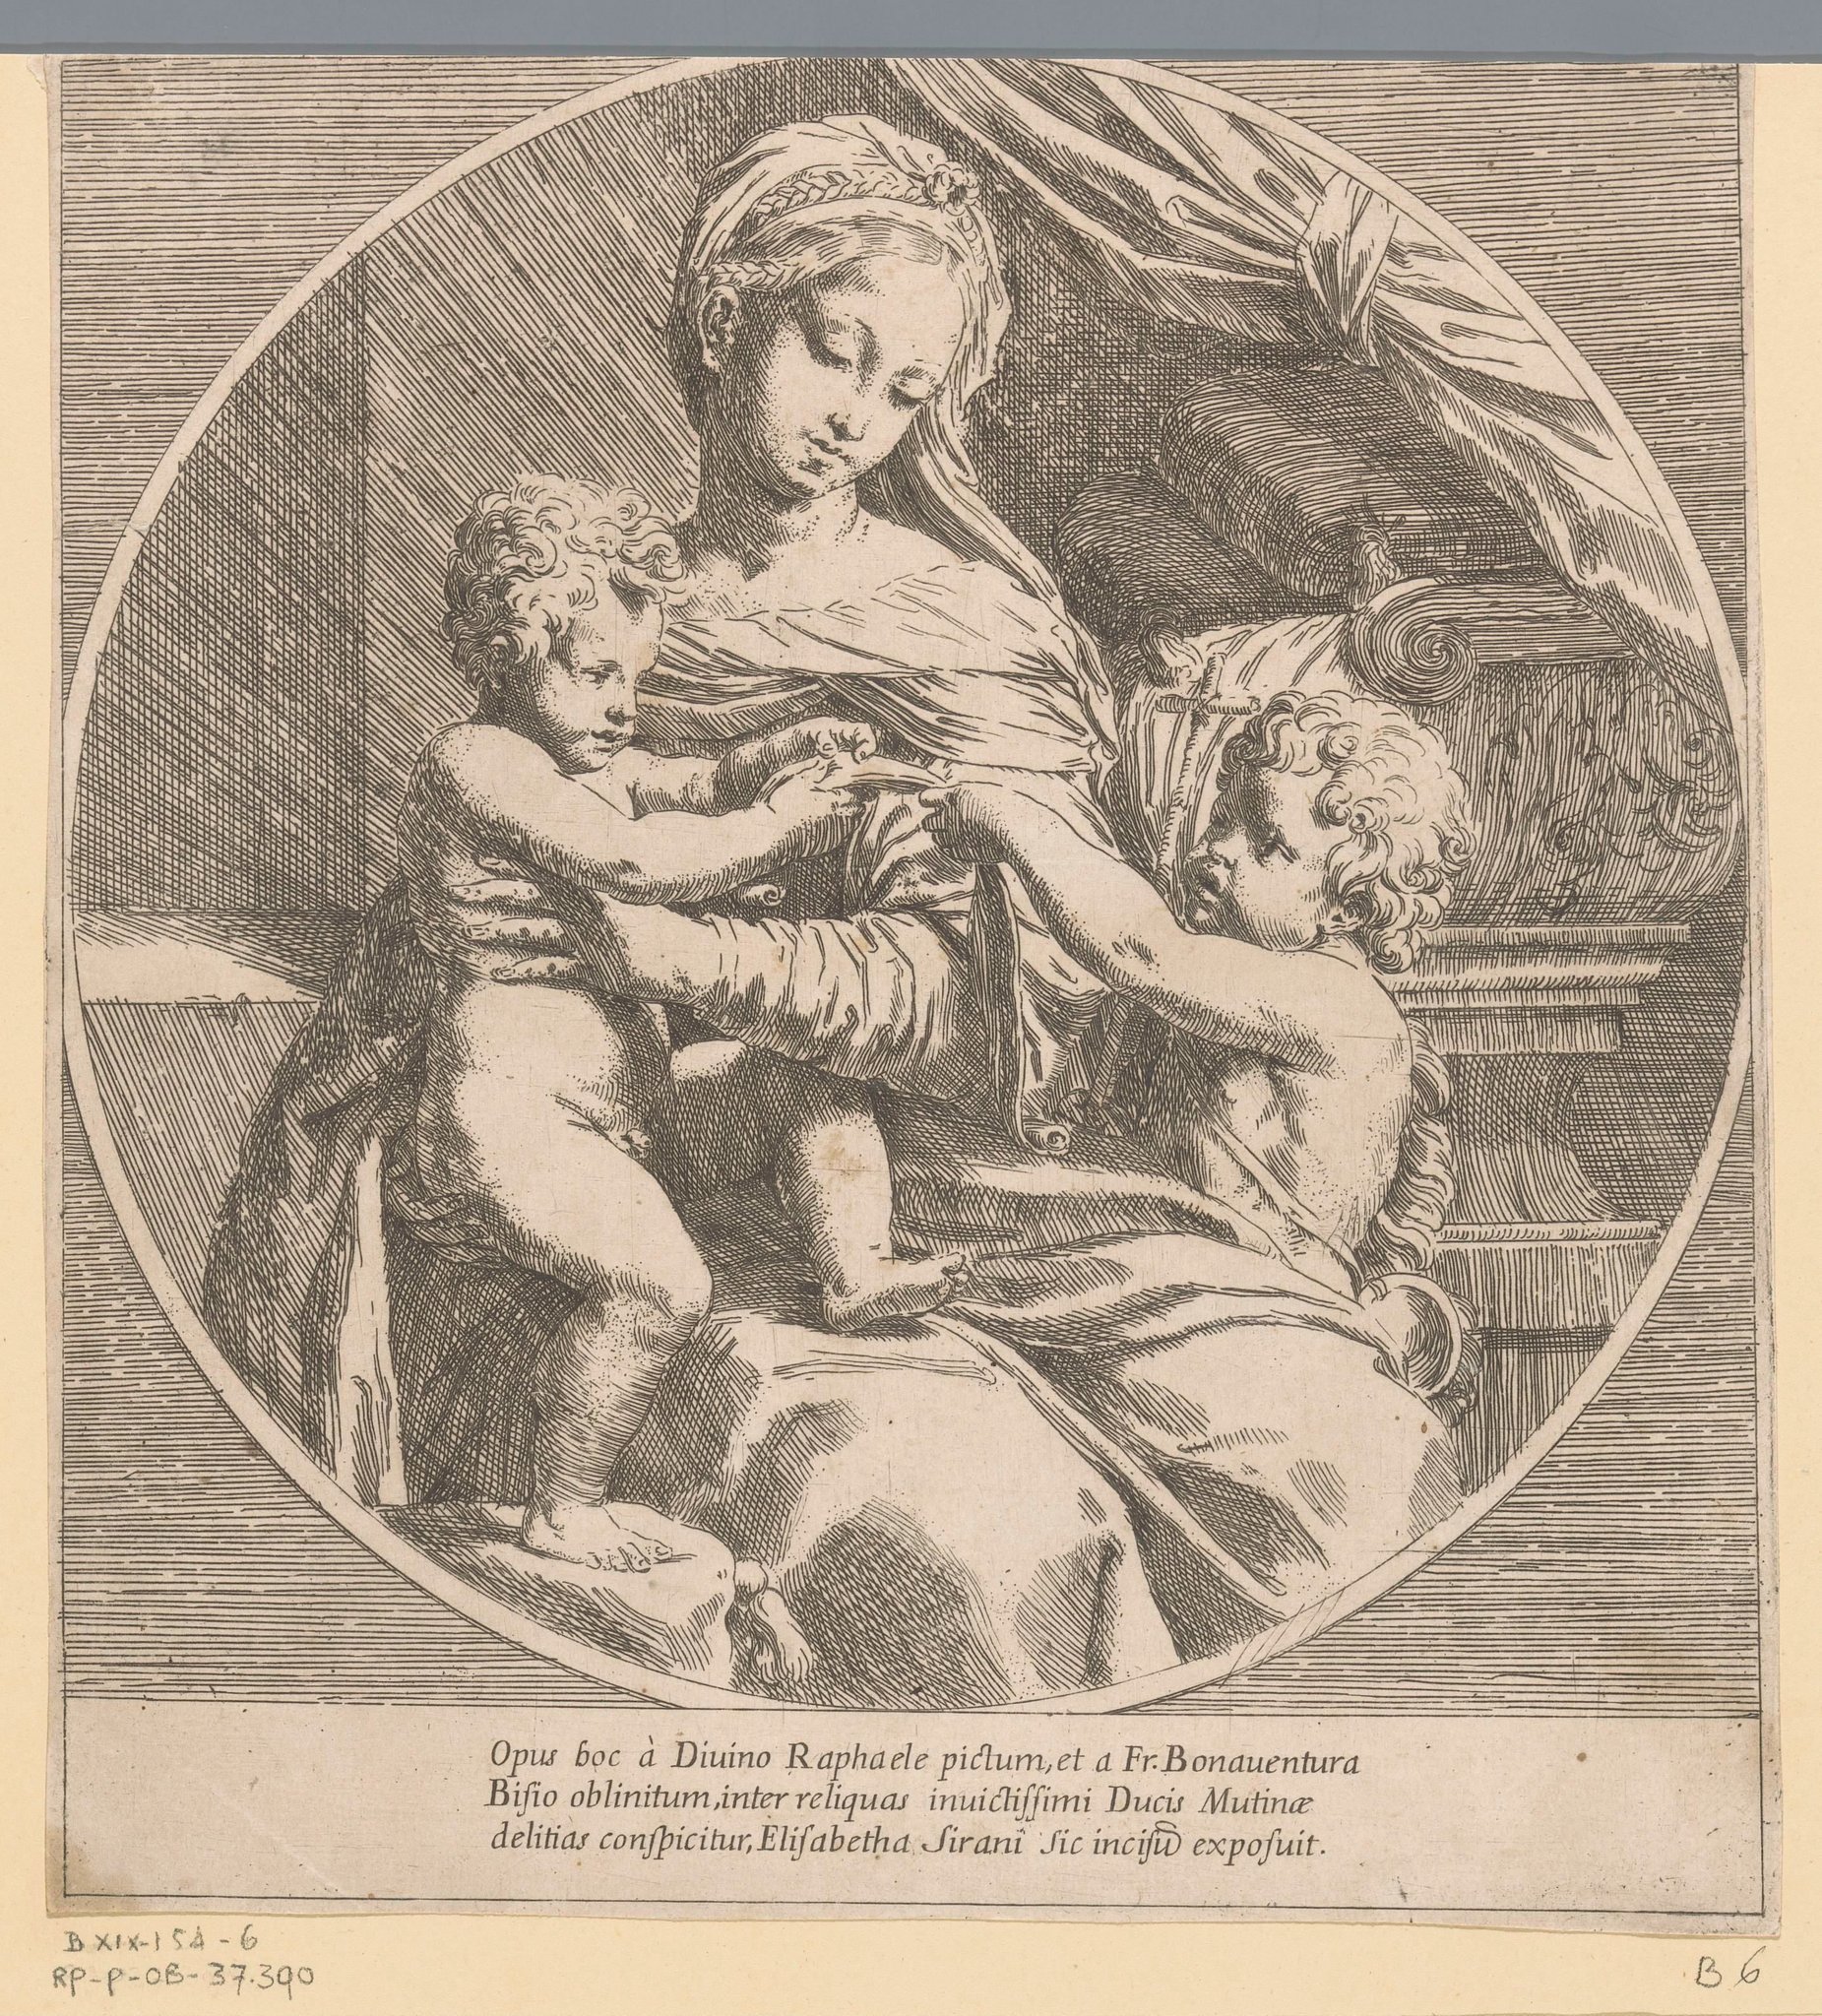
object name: print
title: Maria met Kind en de jonge Johannes de Doper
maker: elisabetta sirani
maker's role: draughtsman, print maker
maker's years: 1638-1665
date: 1648-1665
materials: paper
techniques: etching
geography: italy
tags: mary and the christ-child with john the baptist (as child)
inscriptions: collector's mark: Lugt 240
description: Drieregelige Latijnse tekst in ondermarge.